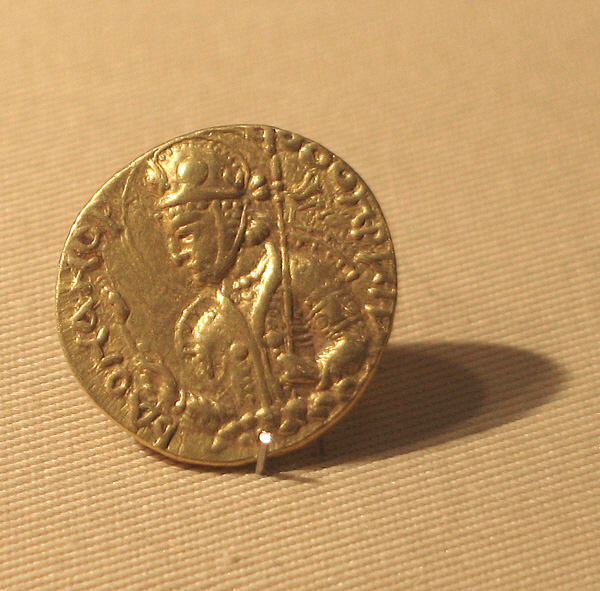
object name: coin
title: Coin of Huvishka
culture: gandhara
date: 150-180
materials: gold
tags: gandhara